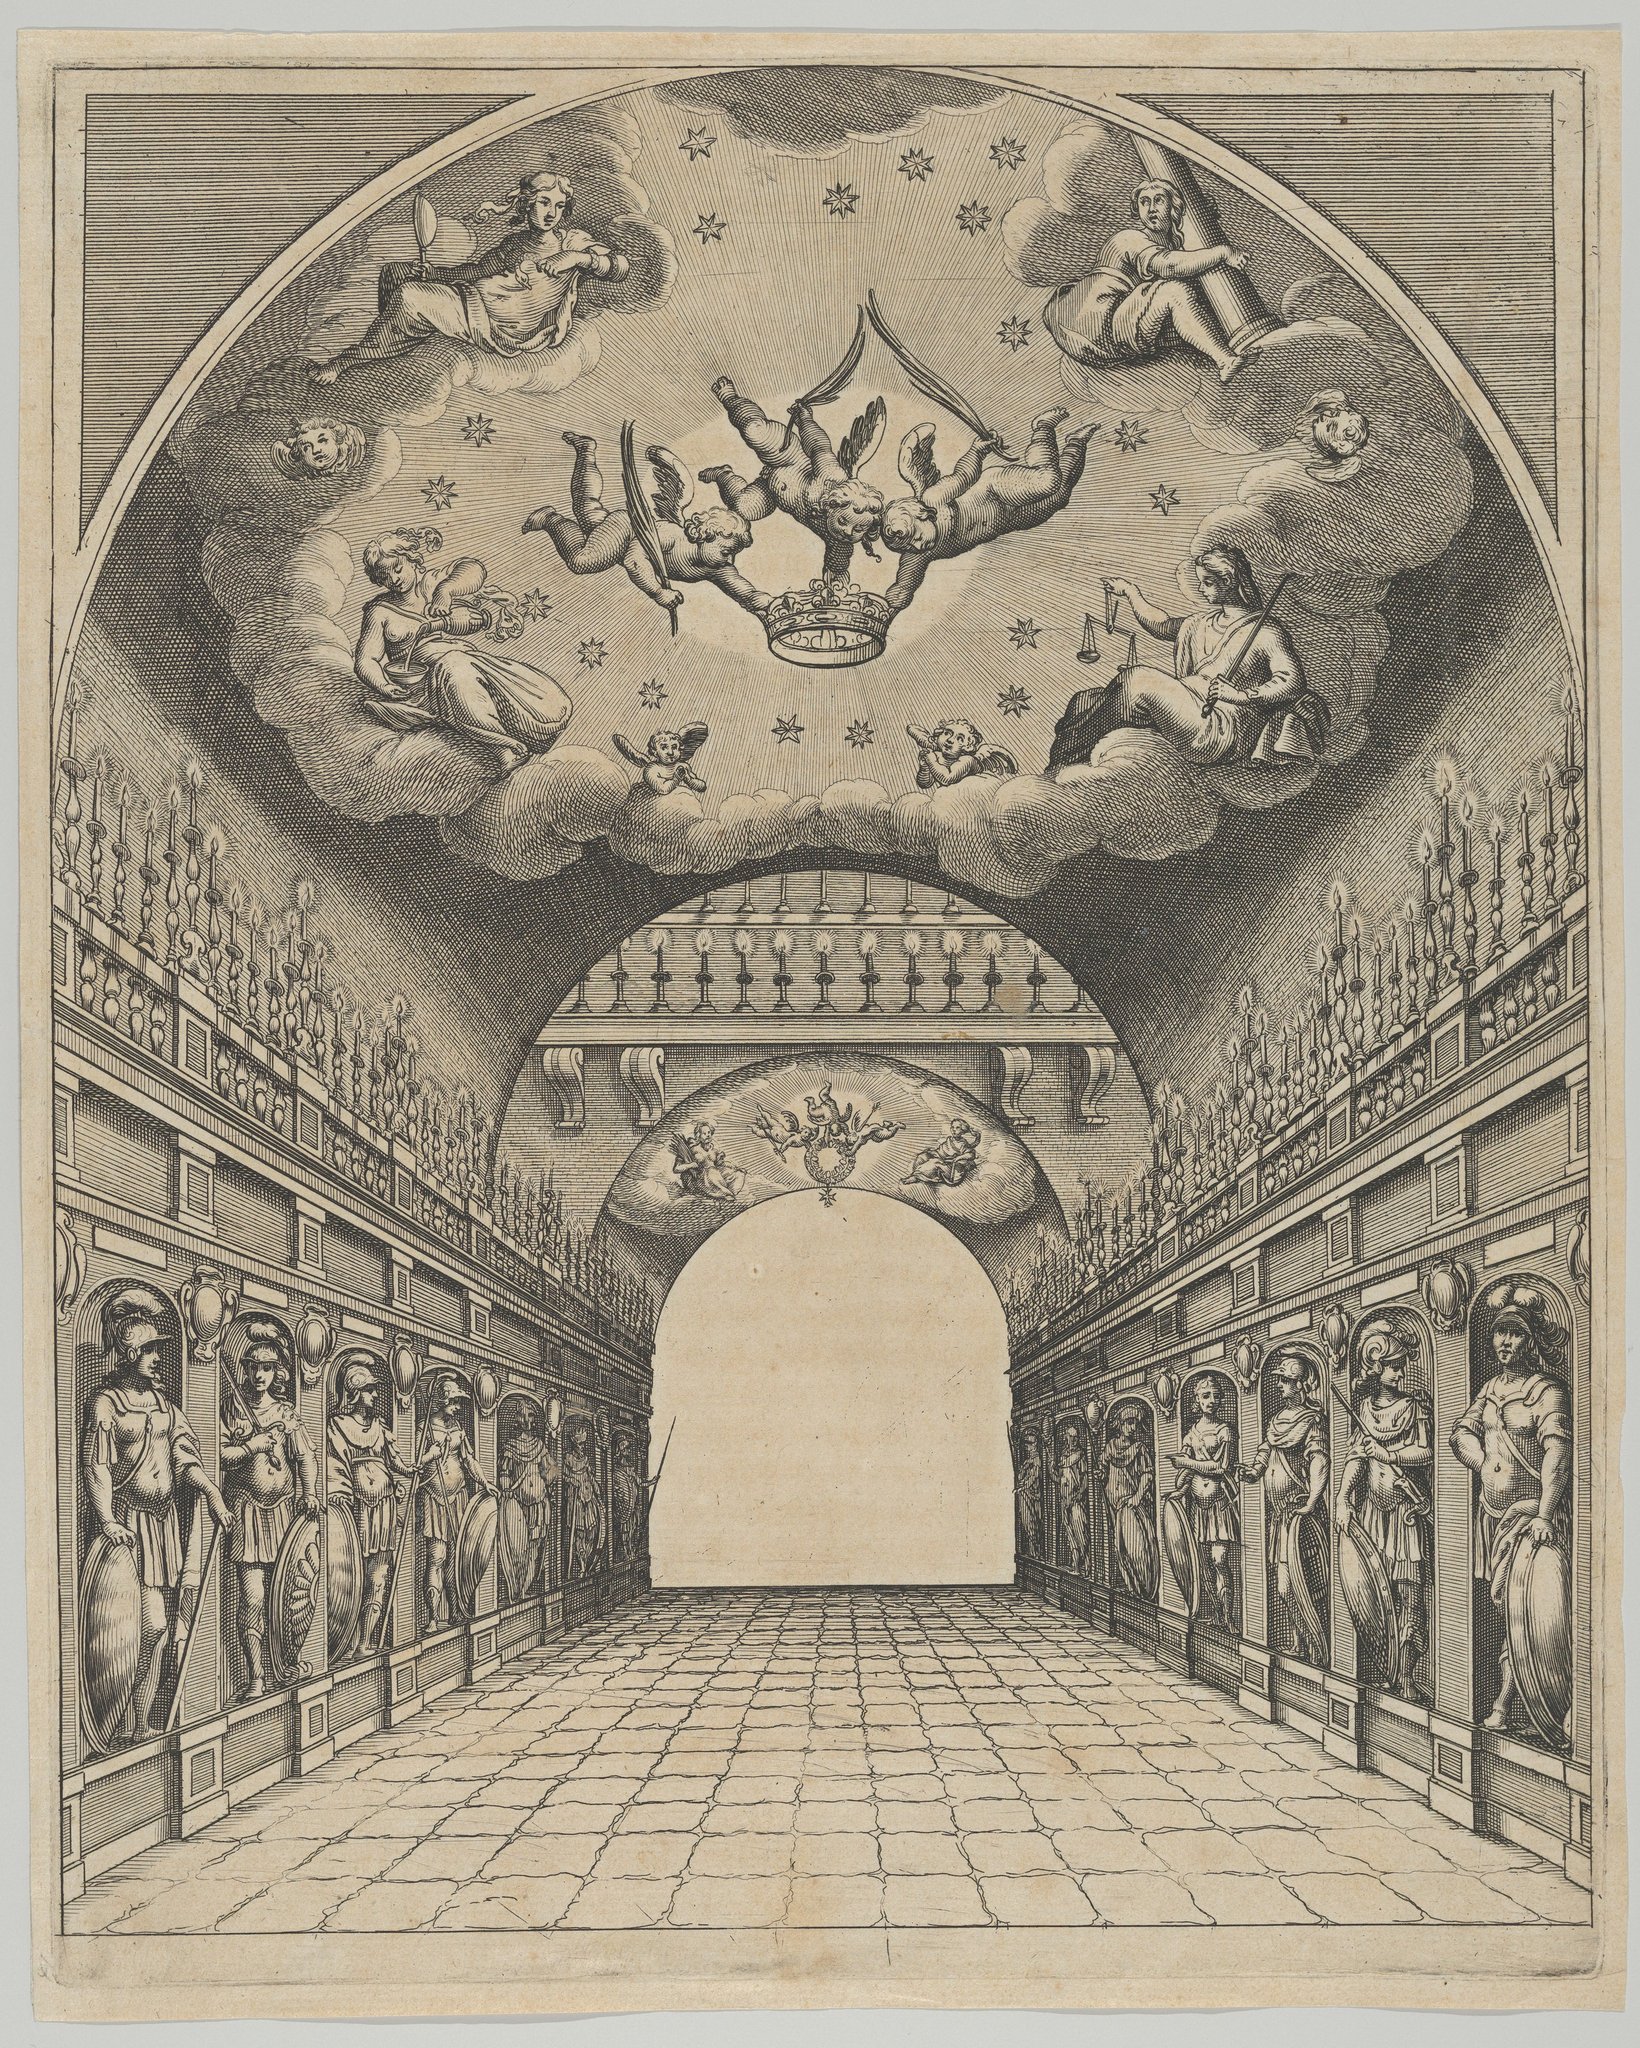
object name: print, fete, ornament architecture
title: Great hall, from 'Éloges et discours sur la triomphante réception du Roy en sa ville de Paris ...' by Jean-Baptiste de Machault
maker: melchior tavernier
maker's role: artist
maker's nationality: french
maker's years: 1564-1641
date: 1629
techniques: etching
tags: architecture,soldiers,putti